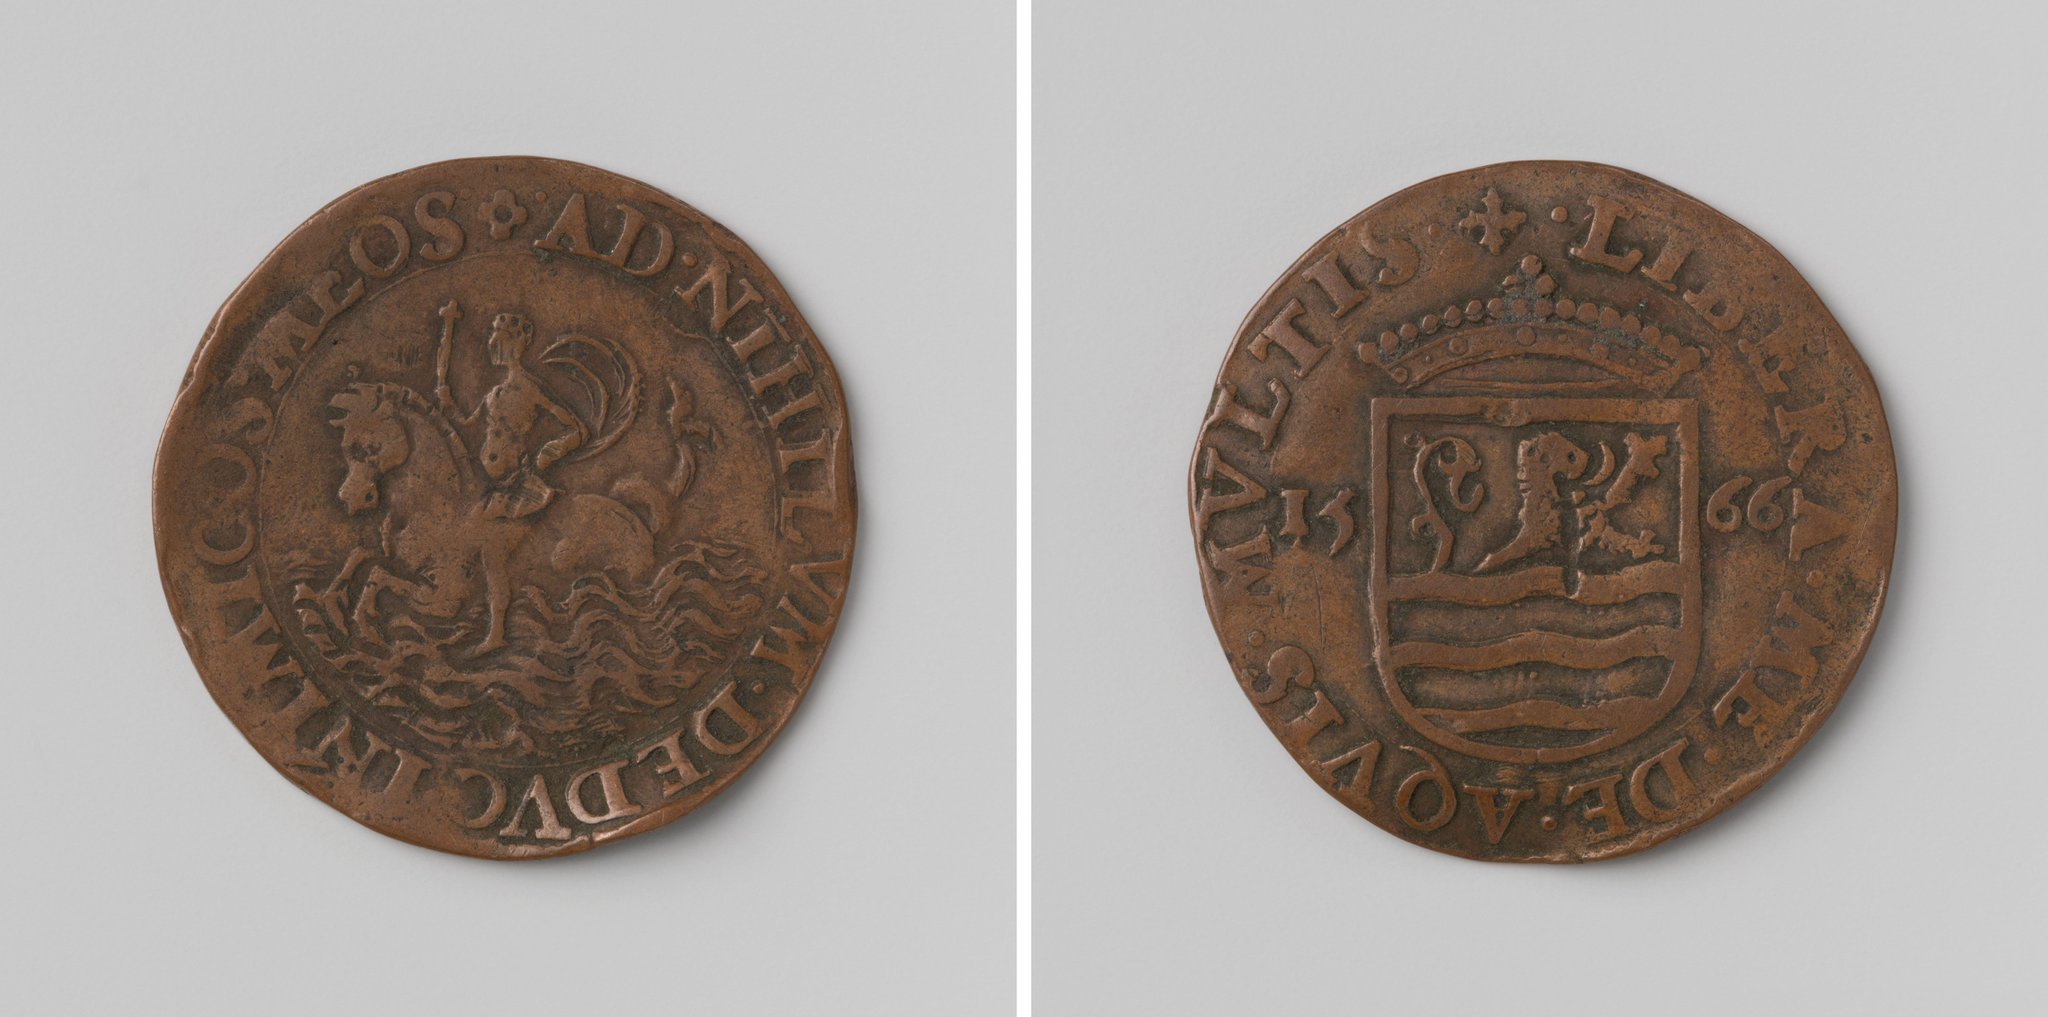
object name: jeton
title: Vrees voor de komend onderdrukking, penning geslagen door de Staten van Zeeland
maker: Anonymous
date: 1566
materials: copper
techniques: striking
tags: zeeland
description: Penning. Voorzijde: man met kroon en scepter, zittend op paard midden in water binnen omschrift. Keerzijde: gekroond wapenschild tussen jaartal binnen omschrift.